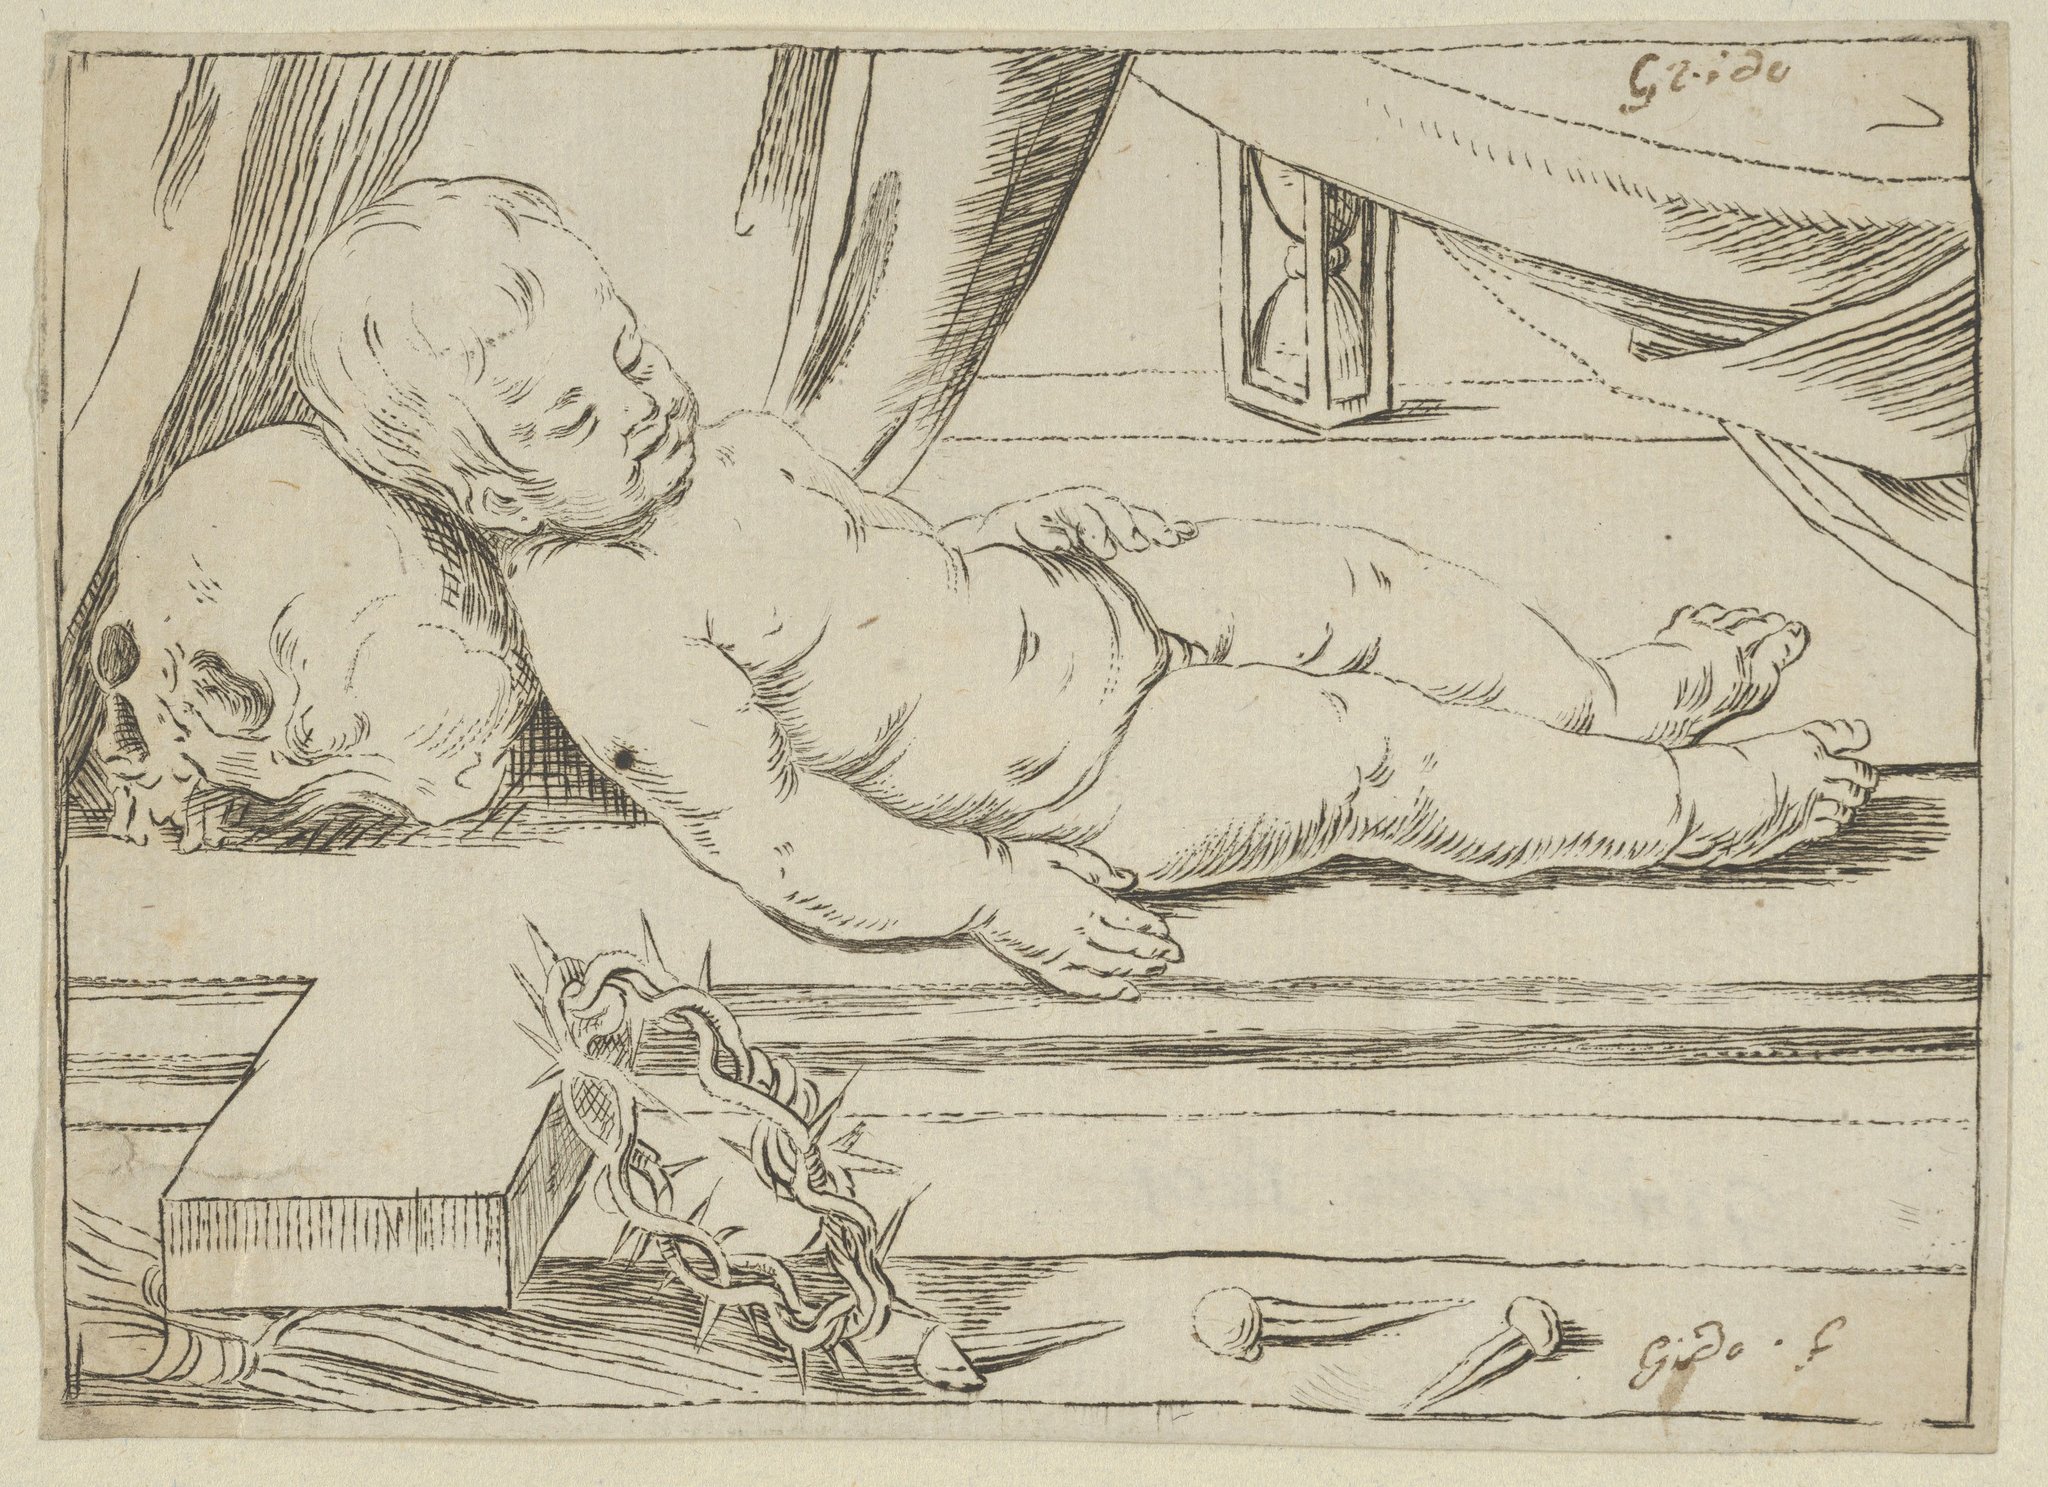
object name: print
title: The infant Christ asleep on a cross, his head resting on a skull, a crown of thorns and nails in the foreground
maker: anonymous, italian, 17th century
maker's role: artist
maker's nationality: italian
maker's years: 1600-1700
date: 1601-1700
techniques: etching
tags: skulls,cross,jesus